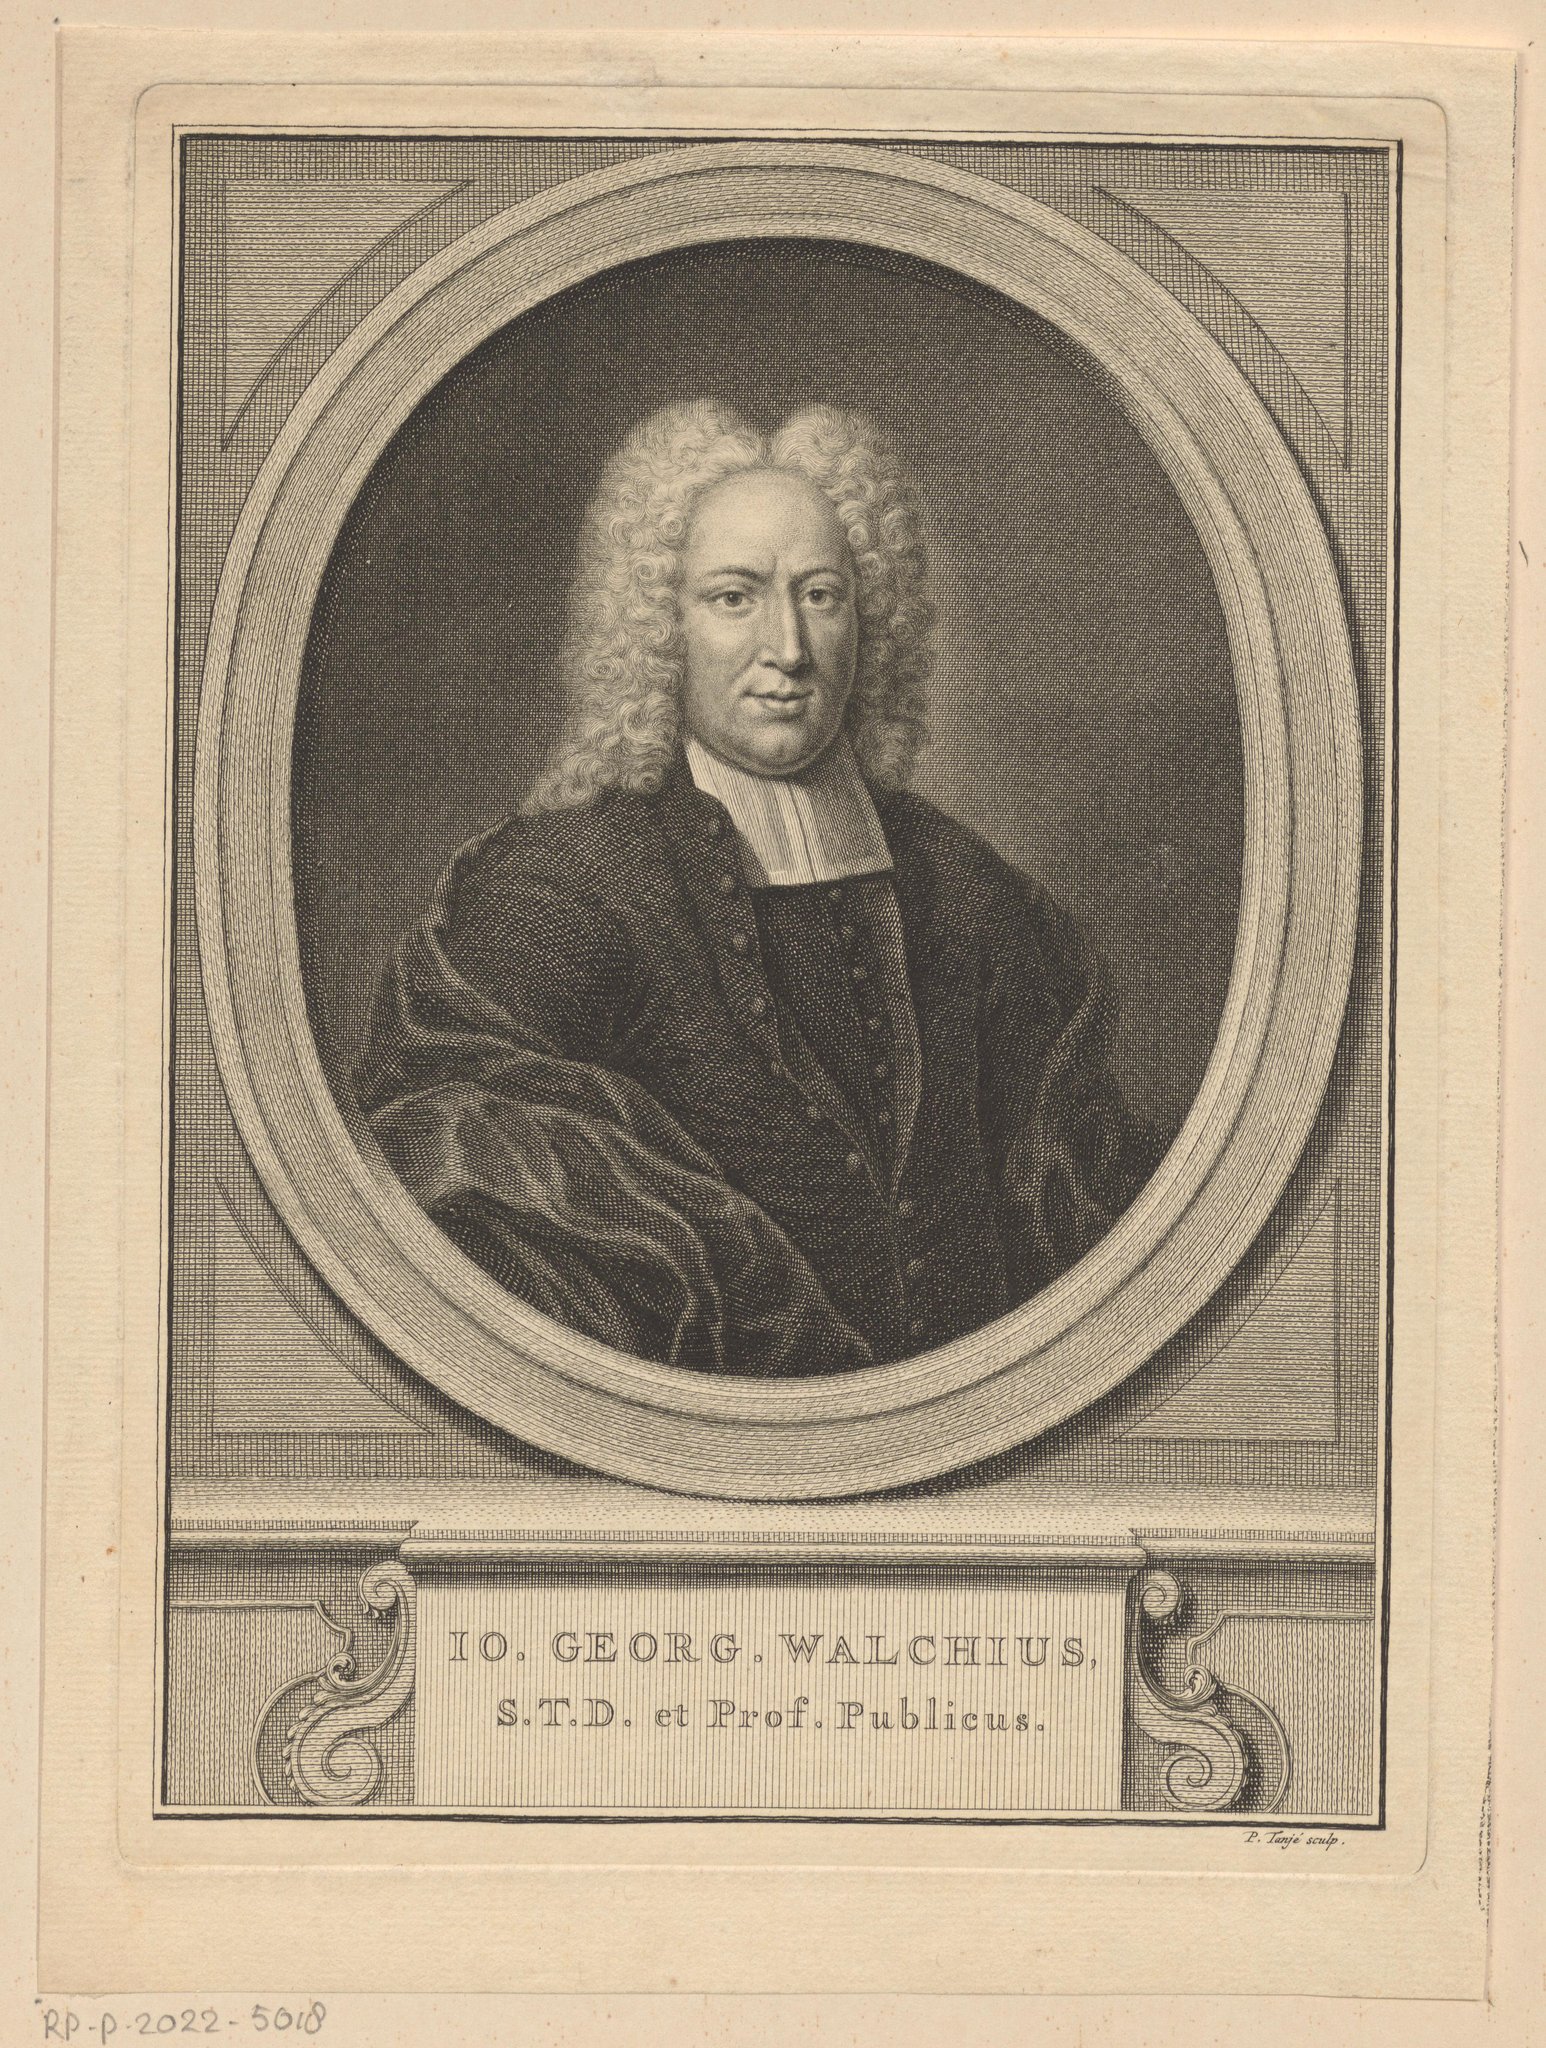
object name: print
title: Portret van Johann Georg Walch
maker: pieter tanjé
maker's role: draughtsman, print maker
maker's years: 1706-1761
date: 1739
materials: paper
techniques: engraving, etching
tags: theologian, historical persons, professor